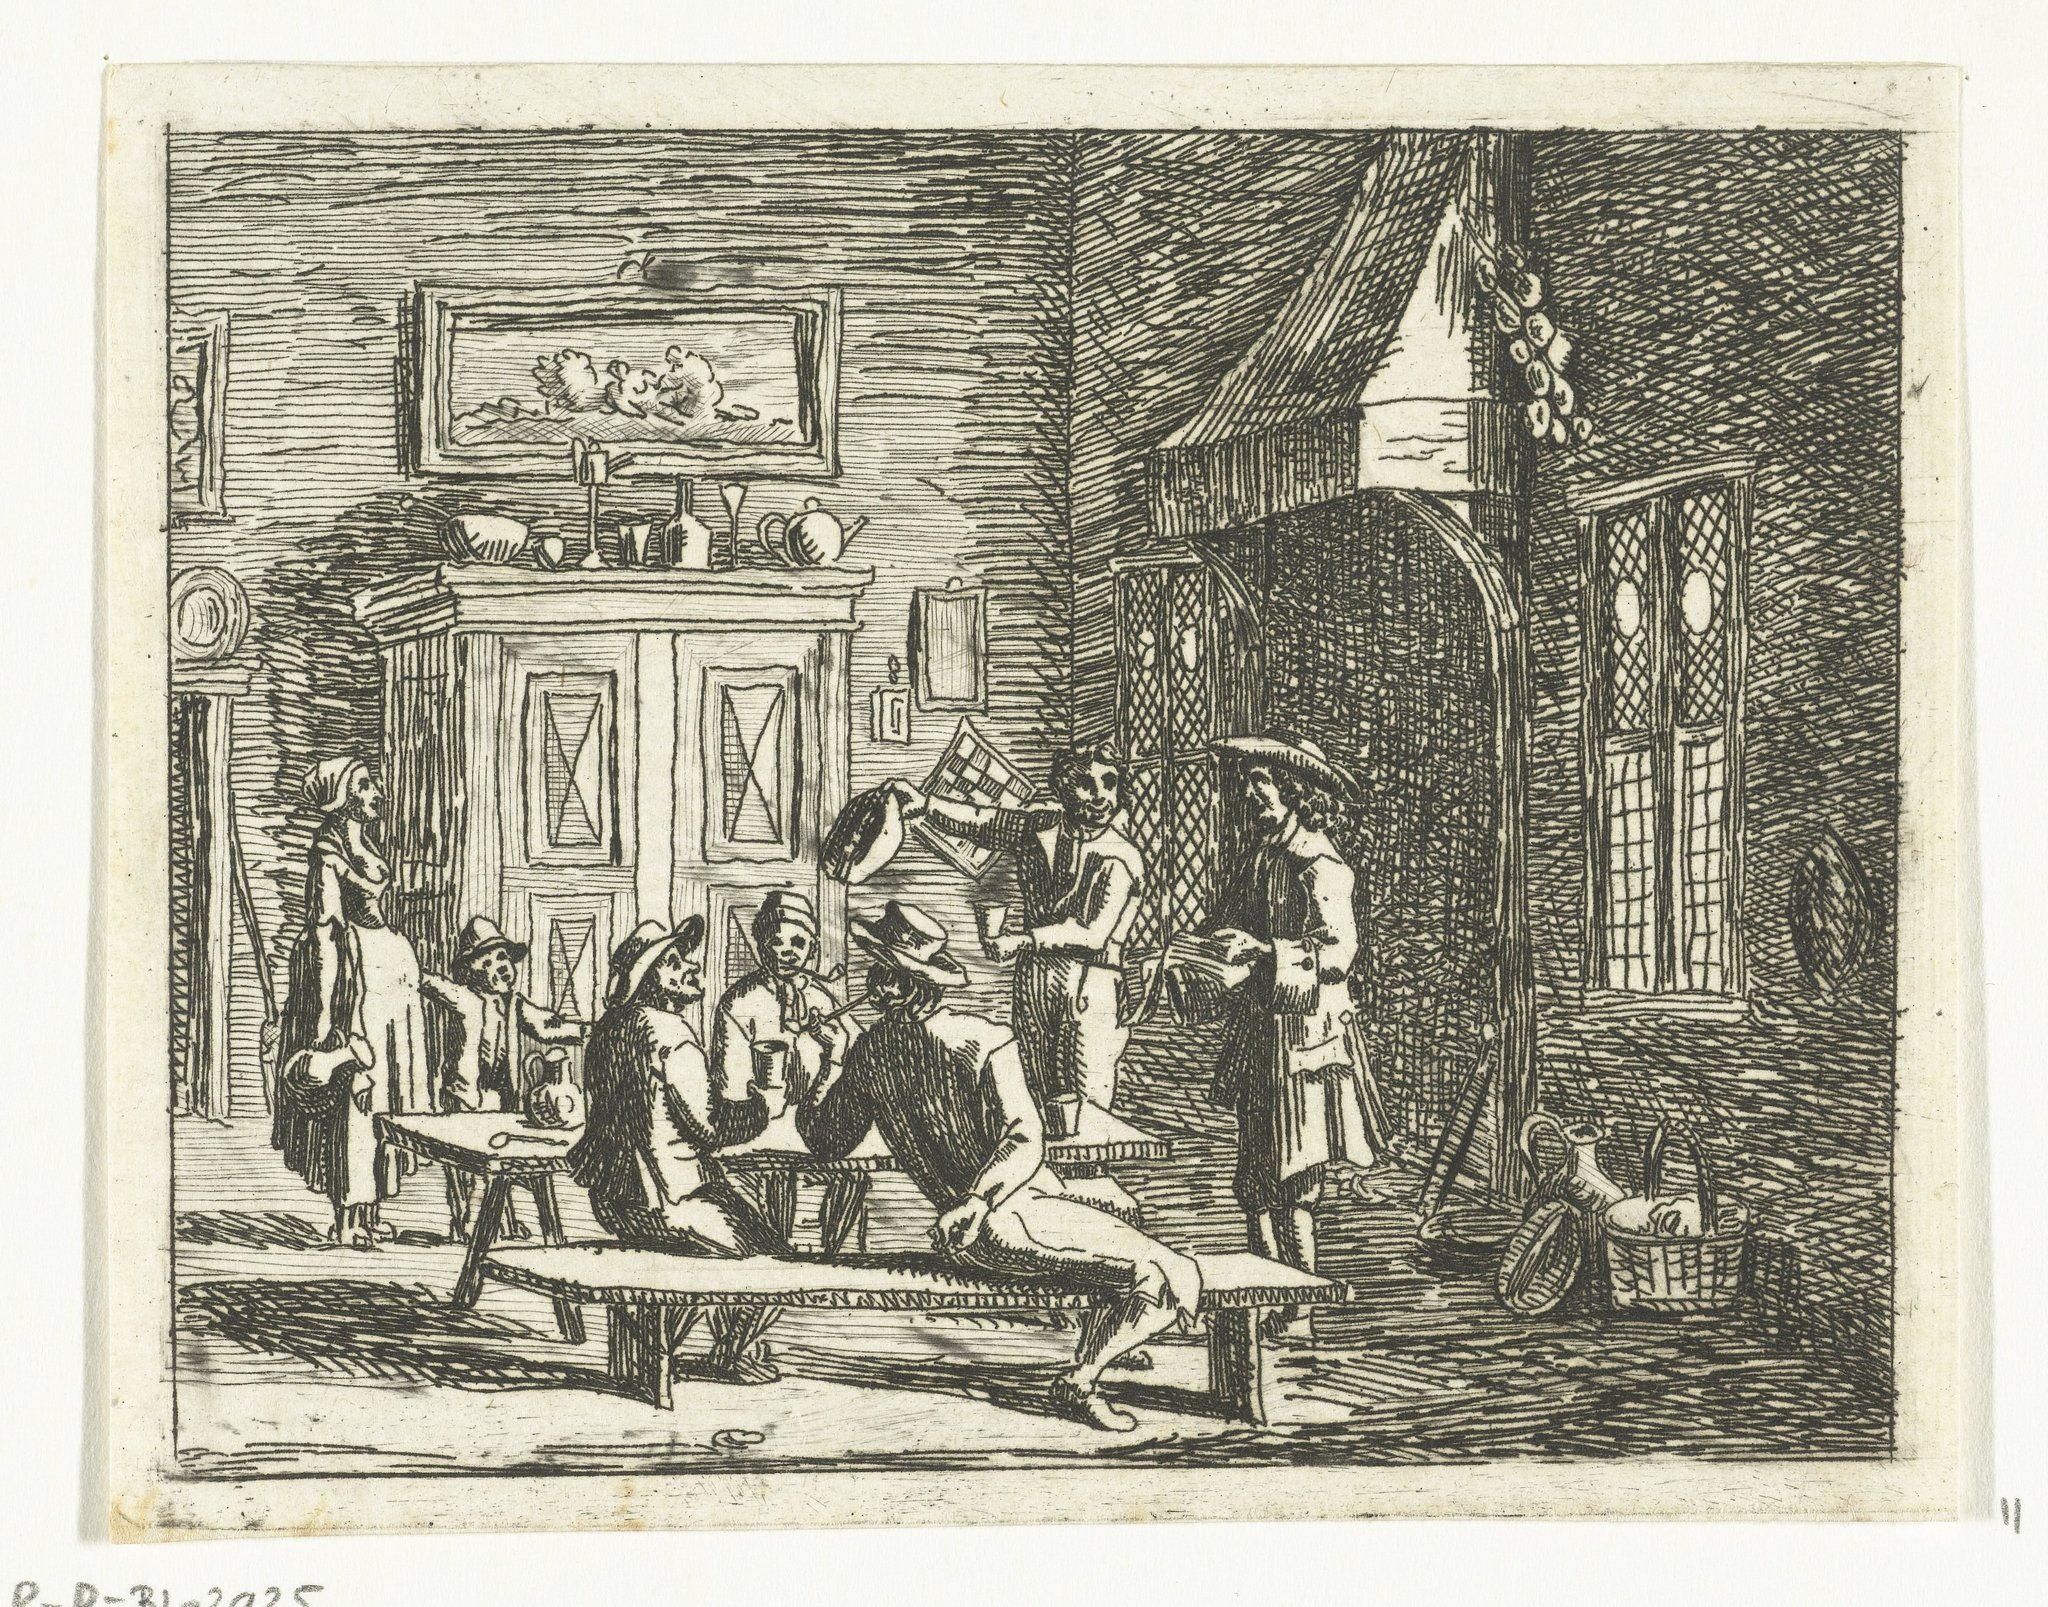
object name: print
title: Interieur van een herberg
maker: anthonie van den bos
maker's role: draughtsman, print maker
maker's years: 1763-1838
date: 1778-1838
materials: paper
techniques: drypoint, etching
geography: netherlands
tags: indoor recreation (+ service ~ indoor recreation), inn, coffee-house, public house, etc. (+ waiter, waitress, etc.), reading to somebody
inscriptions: collector's mark: Lugt 2228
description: Een groep mannen zit aan tafel te drinken en pijp te roken. Een man staat voor de schouw en leest voor uit een pamflet. Een dienstmeid die net nieuwe drank komt brengen blijft staan en luistert aandachtig naar de man.